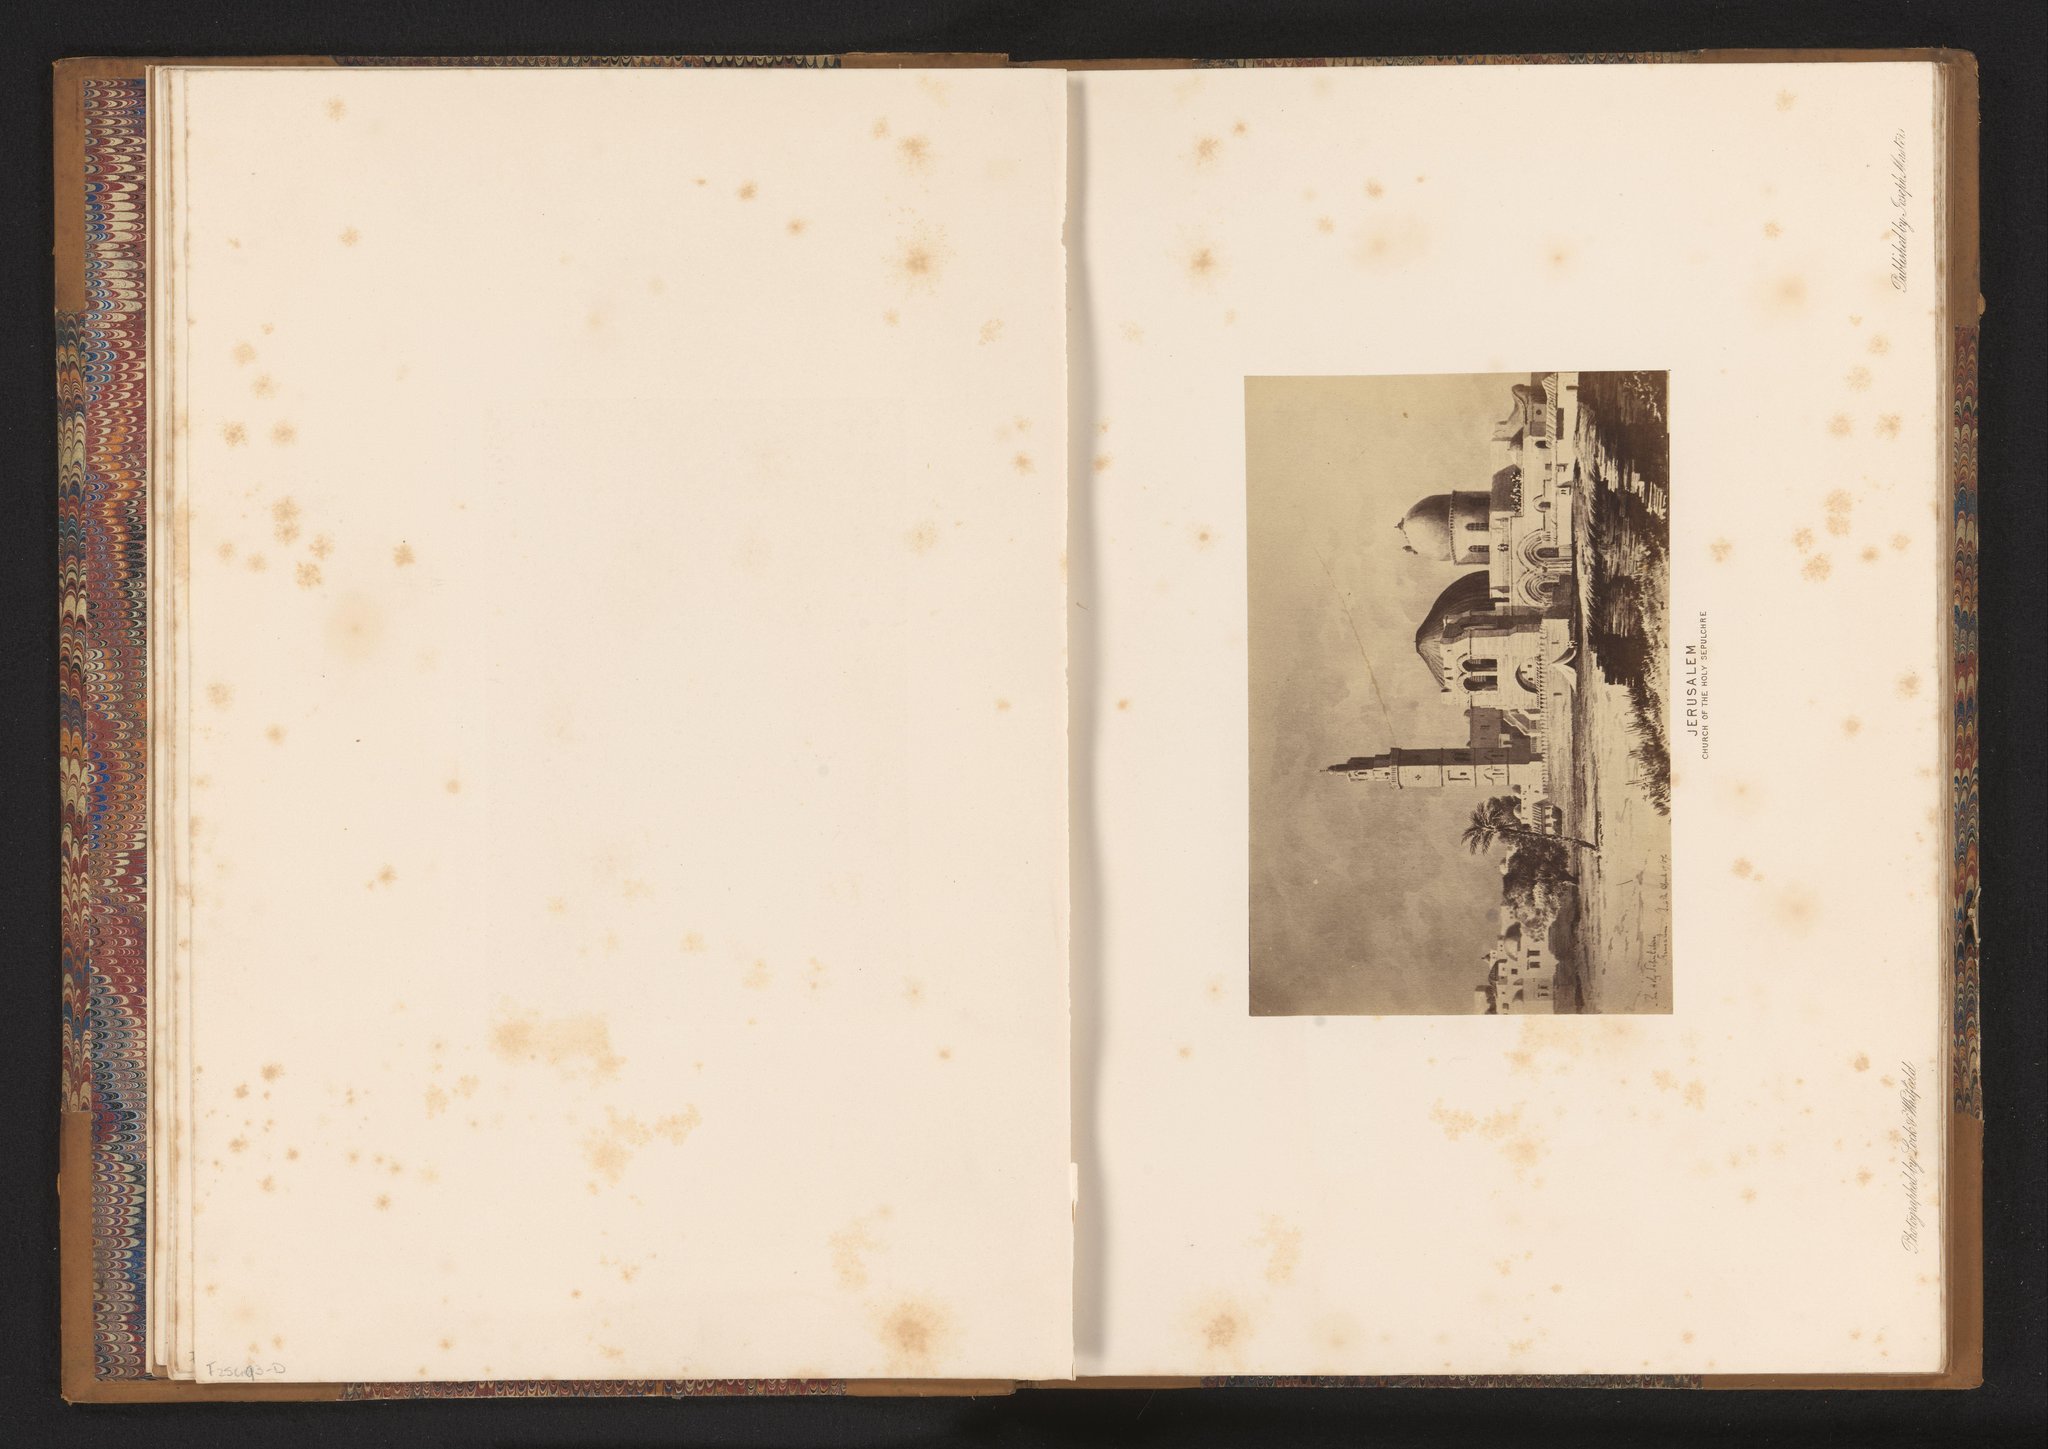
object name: reproduction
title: Jerusalem, Church of the Holy Sepulchre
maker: conway mordaunt shipley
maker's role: draughtsman, painter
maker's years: 1824-1888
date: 1855-1865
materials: paper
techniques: albumen print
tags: roman catholic church